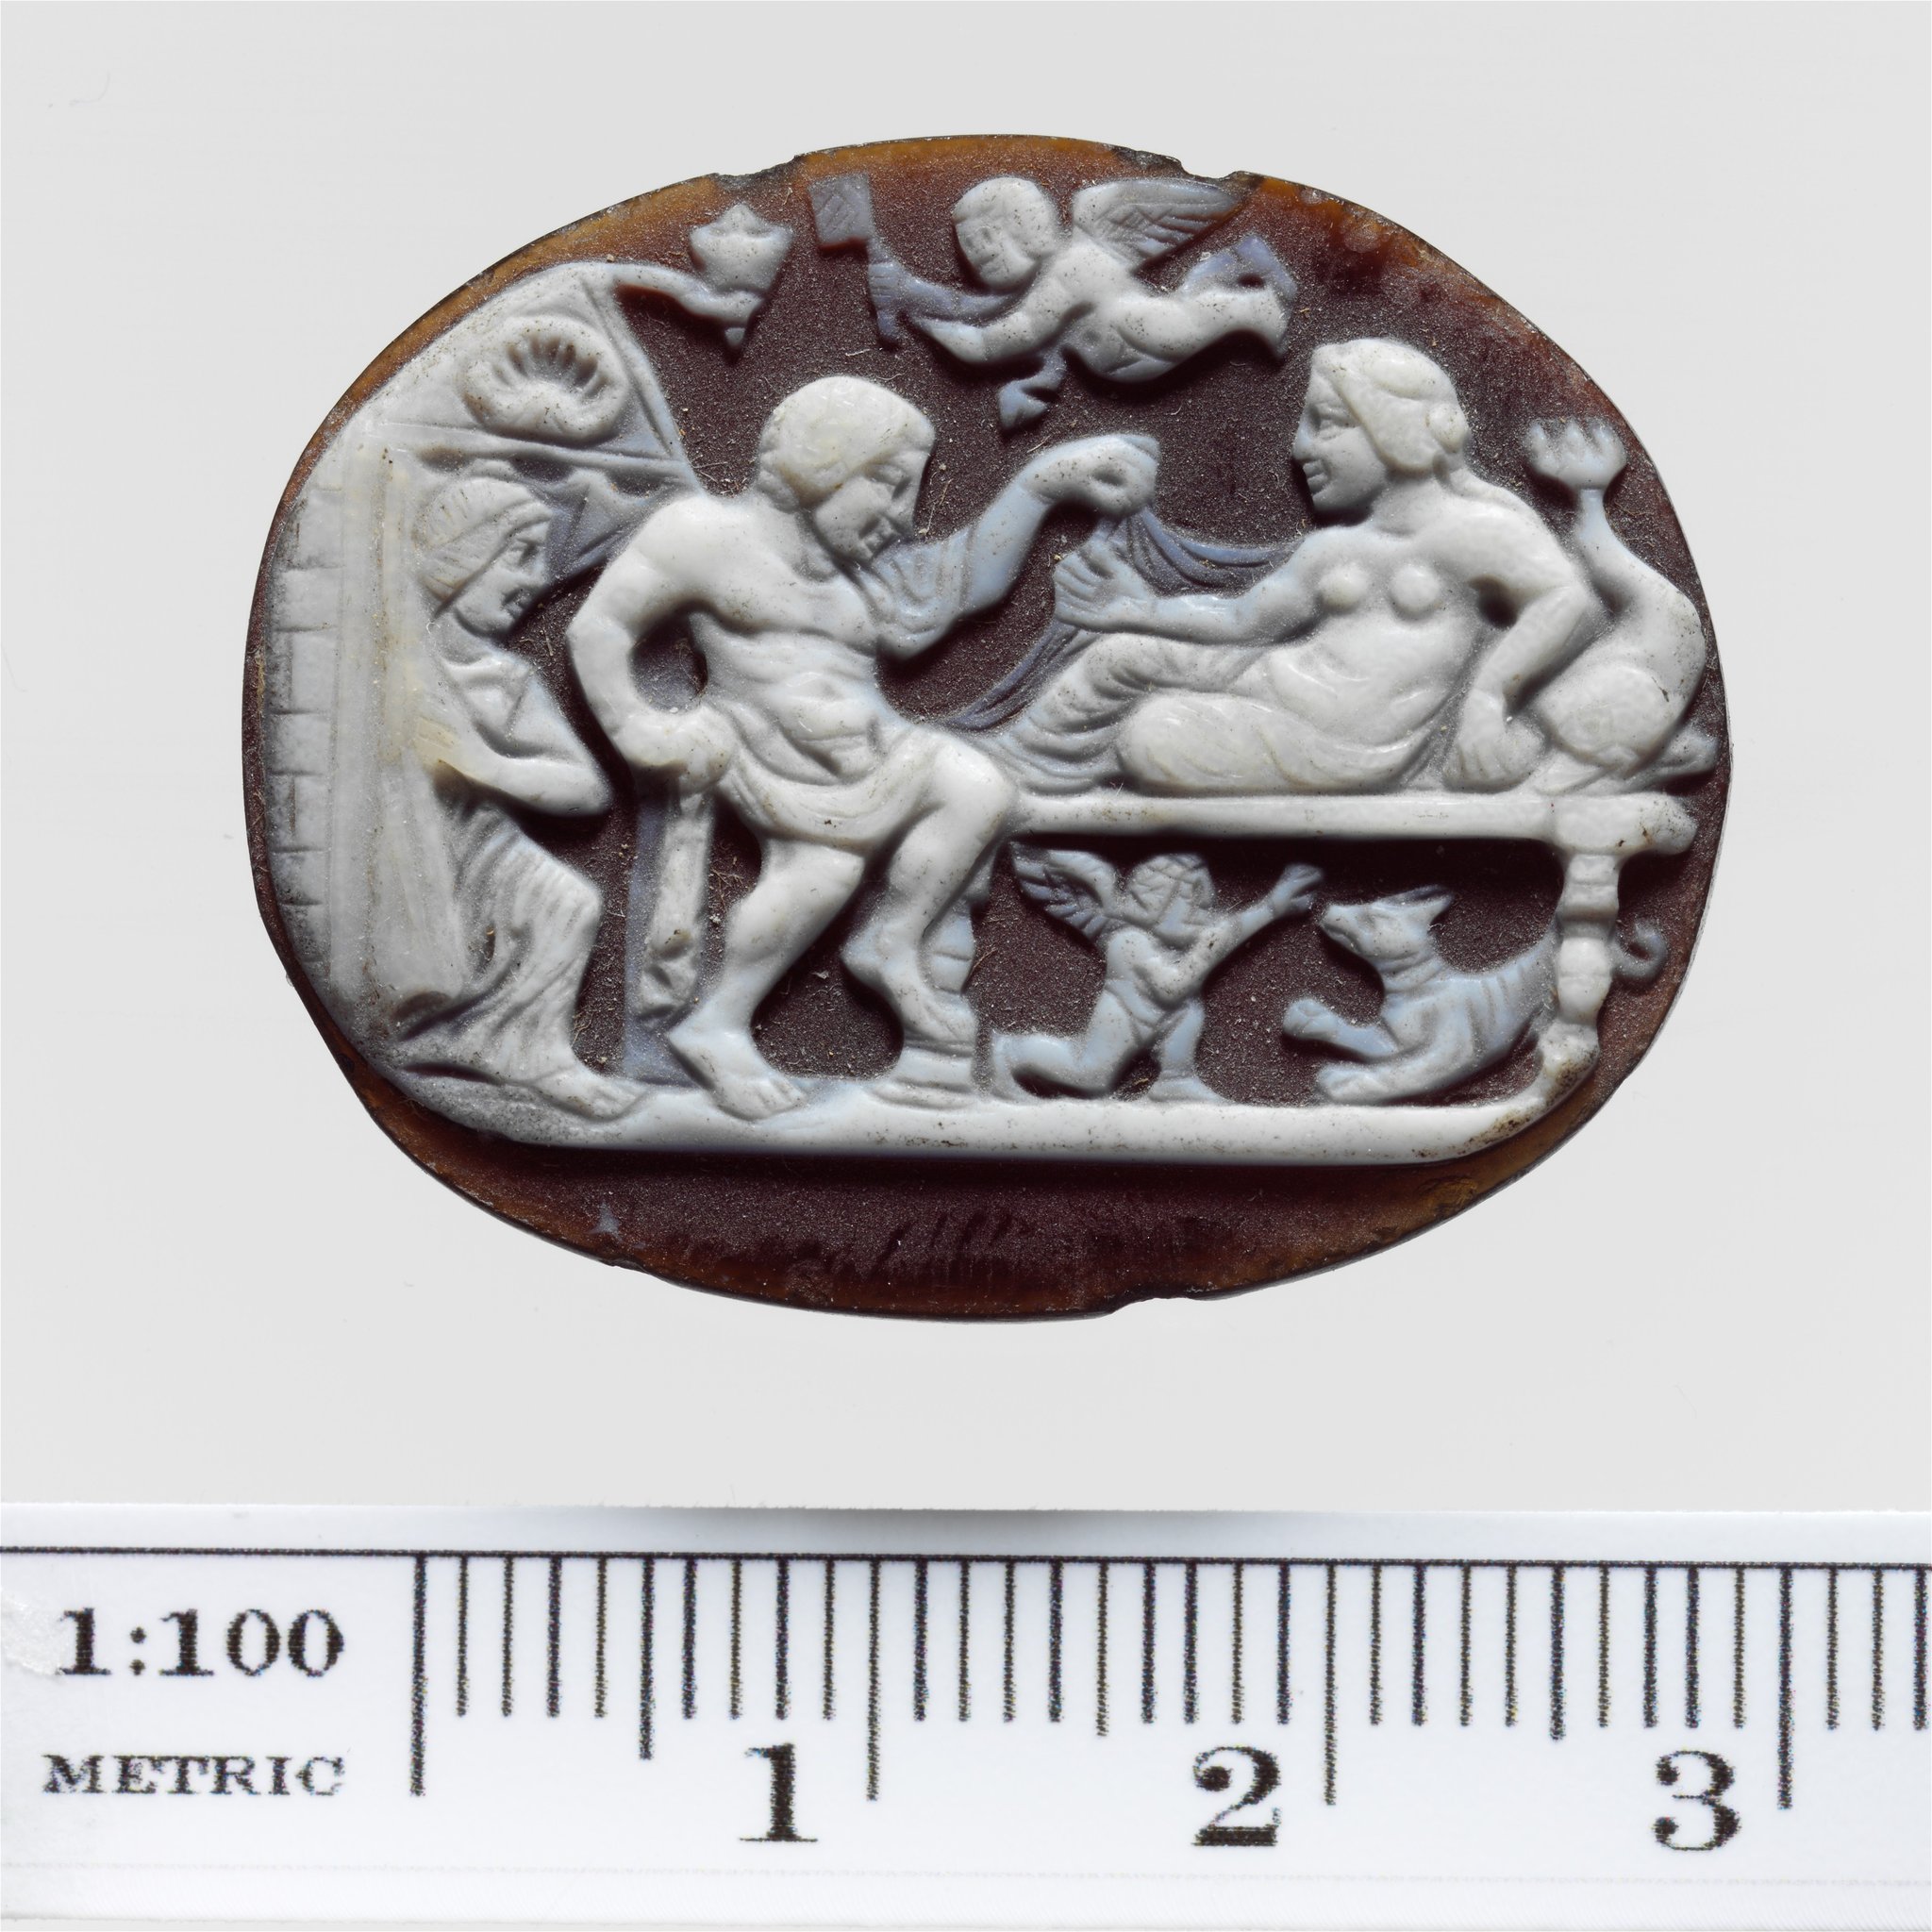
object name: cameo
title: Sardonyx cameo with a man and woman on a couch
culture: greek or roman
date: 100 BCE-100 CE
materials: gemstone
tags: men,women,eros,dogs